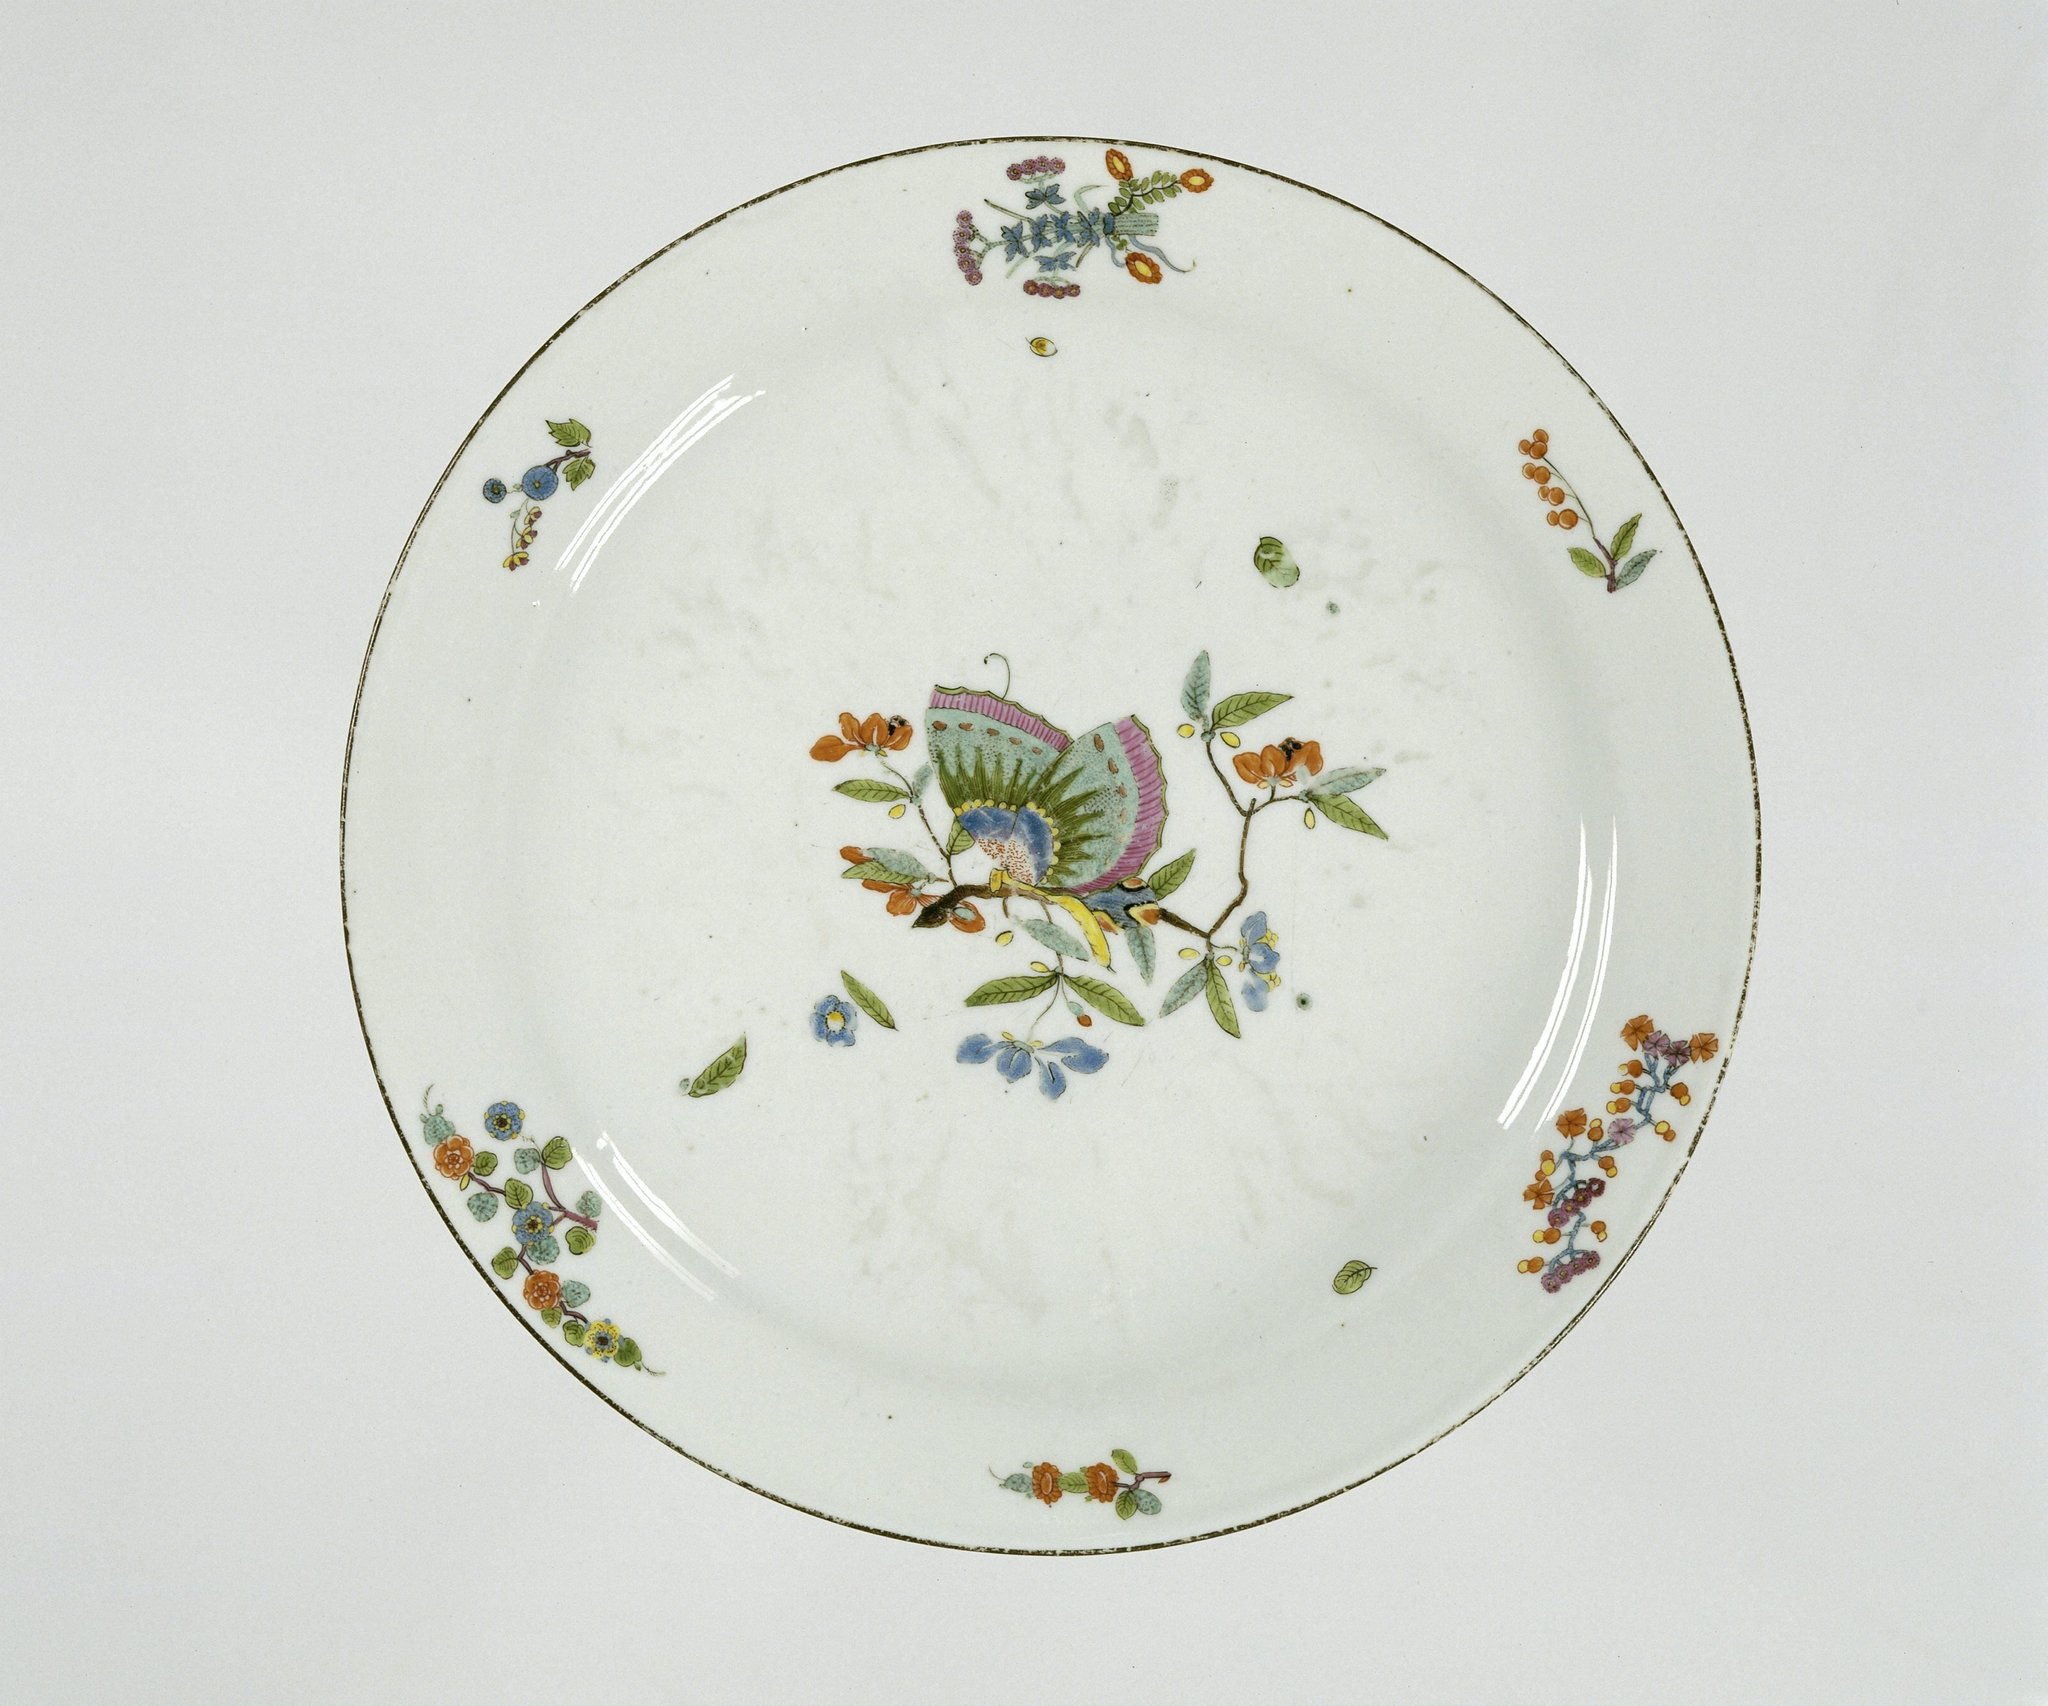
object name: plate dish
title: Bord, veelkleurig beschilderd met bloemtakken en een vlinder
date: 1730-1735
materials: porcelain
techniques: painted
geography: meissen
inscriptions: factory mark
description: Rond bord van veelkleurig beschilderd porselein. Het licht verdiepte bord heeft een smalle rand en is op de spiegel beschilderd met een vlinder op een bloeiende tak en op de rand drie grote bloemtakken afgewisseld door drie kleinere takken. De rand heeft een bruine bies. Het bord is gemerkt.